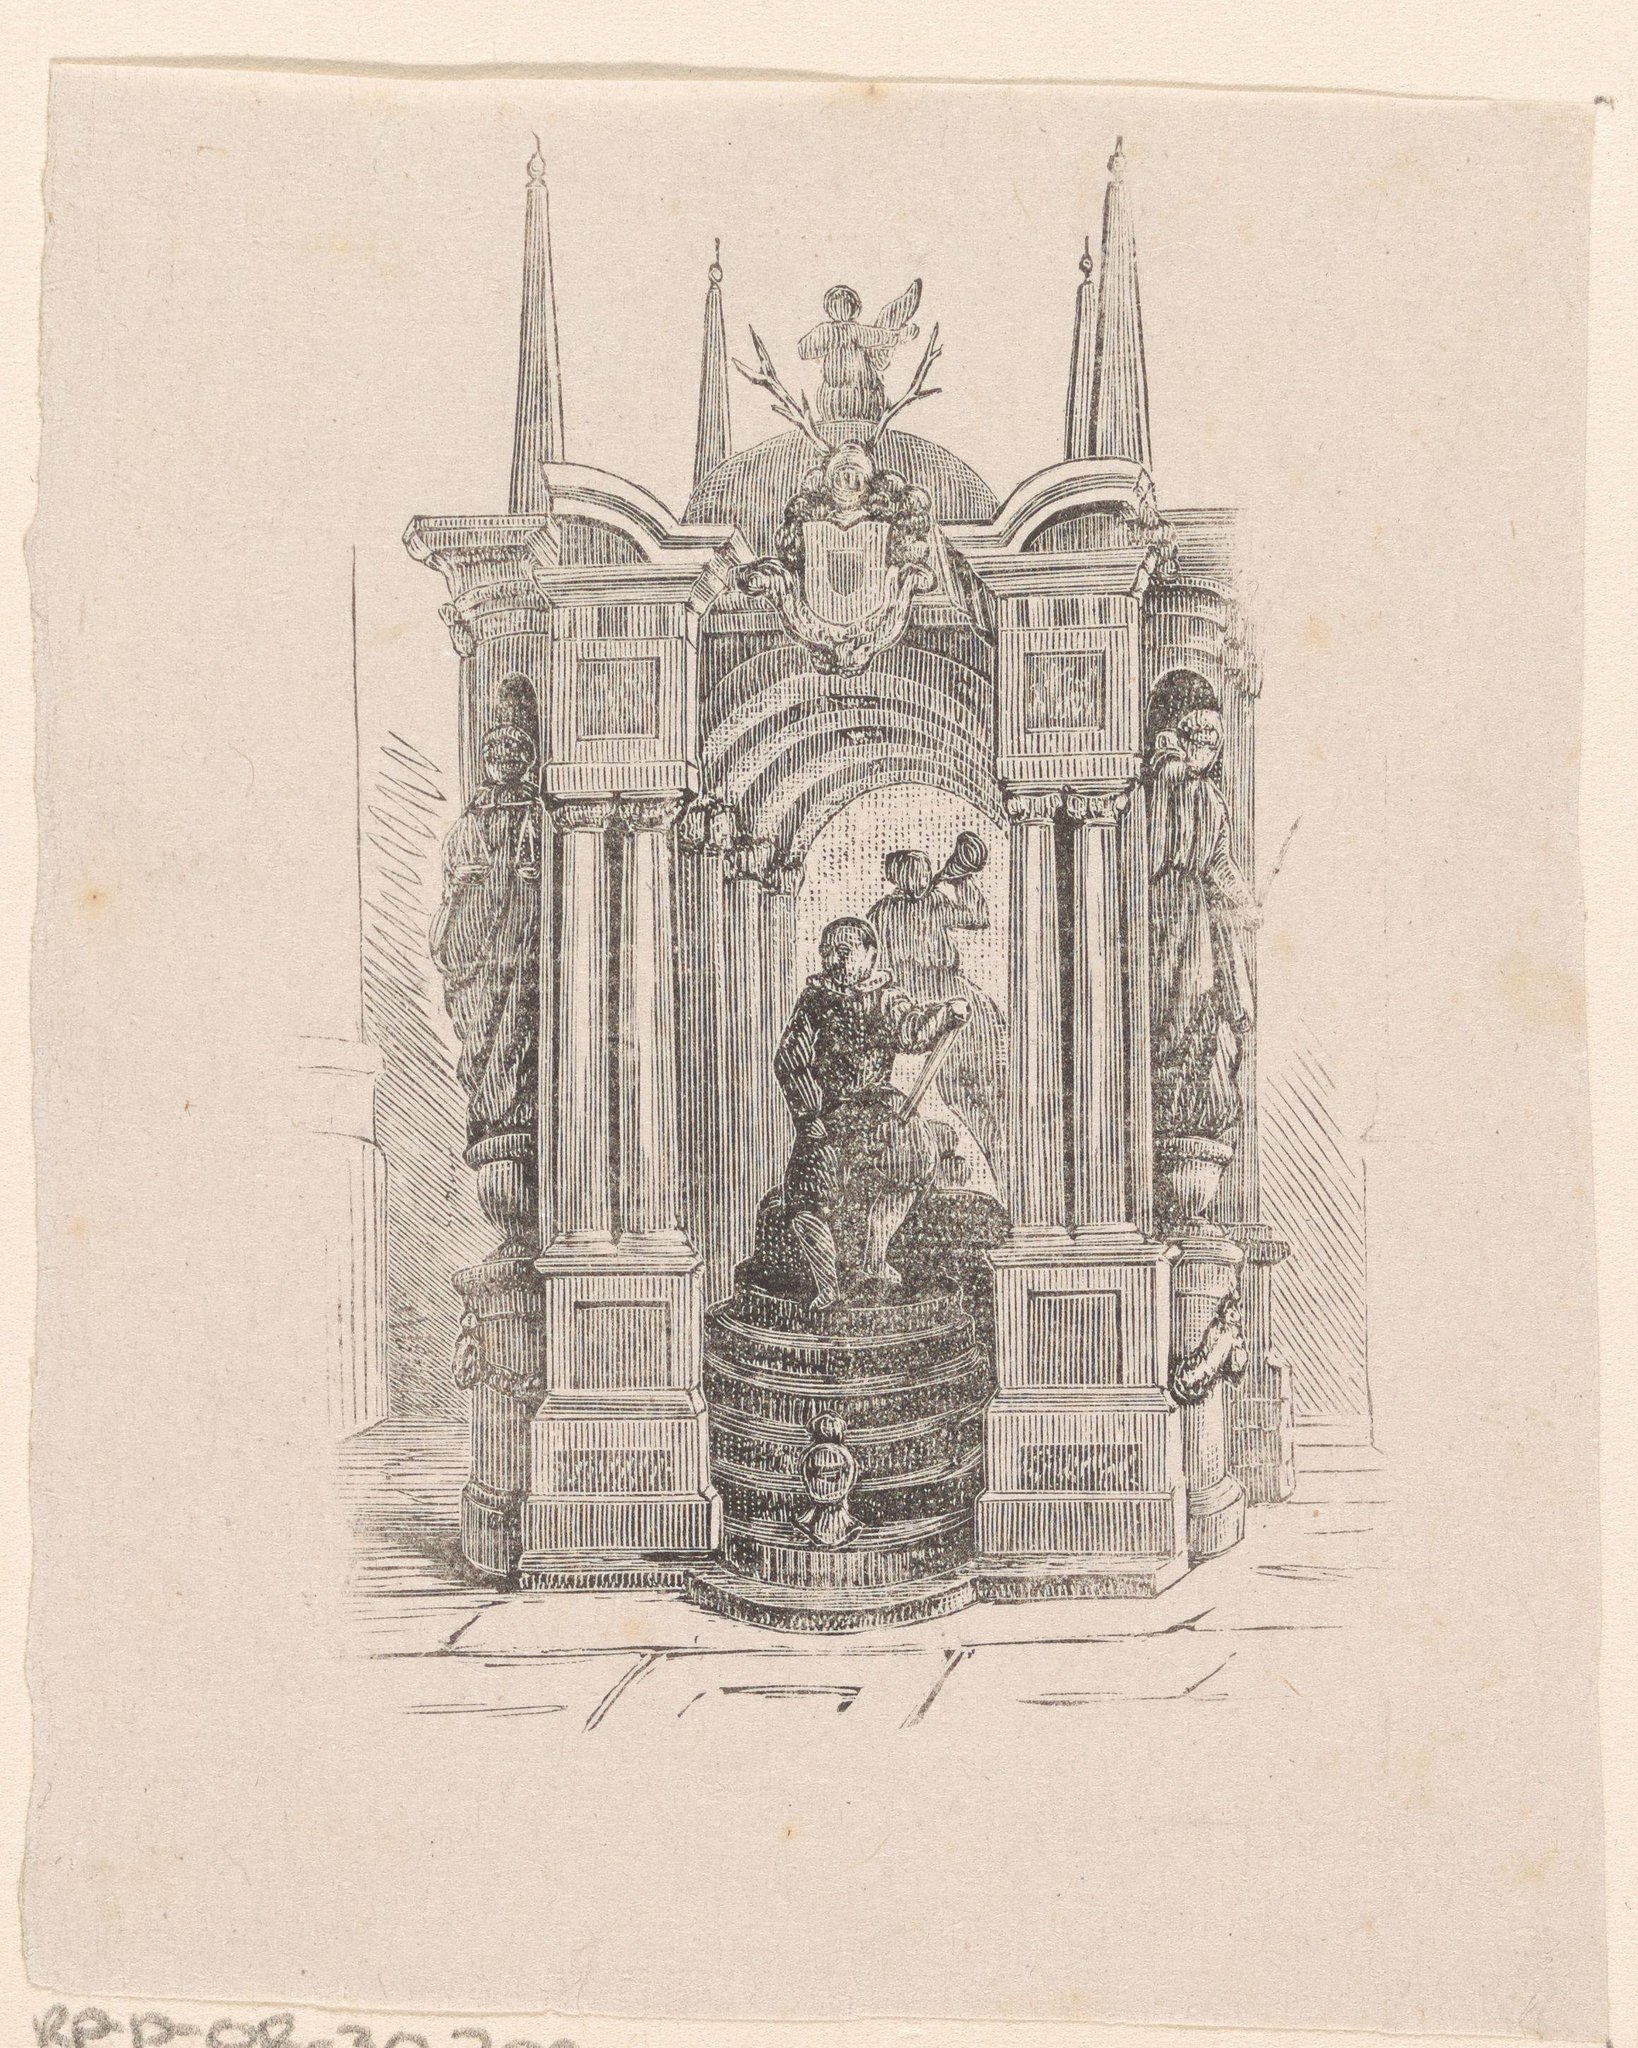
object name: print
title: Graftombe van Willem I, prins van Oranje, in de Nieuwe Kerk te Delft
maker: isaac weissenbruch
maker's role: print maker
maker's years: 1826-1912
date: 1836-1912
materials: paper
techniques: engraving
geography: netherlands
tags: delft, william i (prince of orange), grave-building, monumental tomb